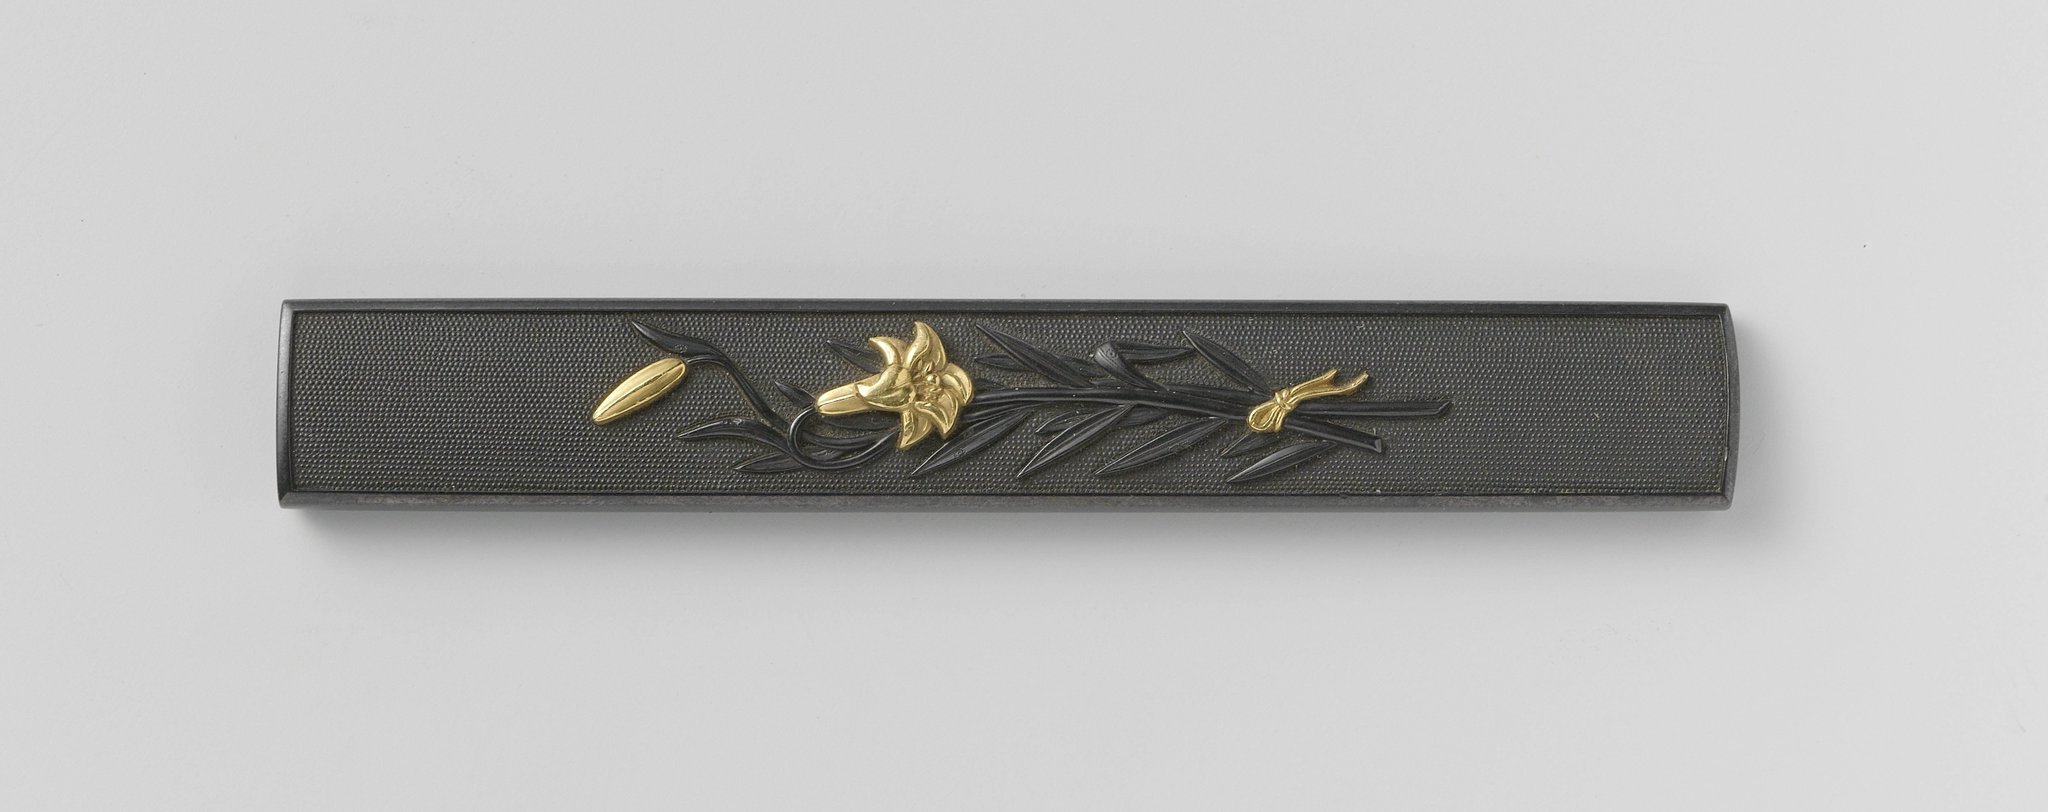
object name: zwaardmesheft, kozuka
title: Sword knife hilt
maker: Anonymous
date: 1500-1900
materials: metal alloy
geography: japan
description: Versiering met een lelietak in reliëf; in goud zijn weergegeven een bloeiende en een gesloten lelie en een draadje om de tak. Zwarte achtergrond en omranding.